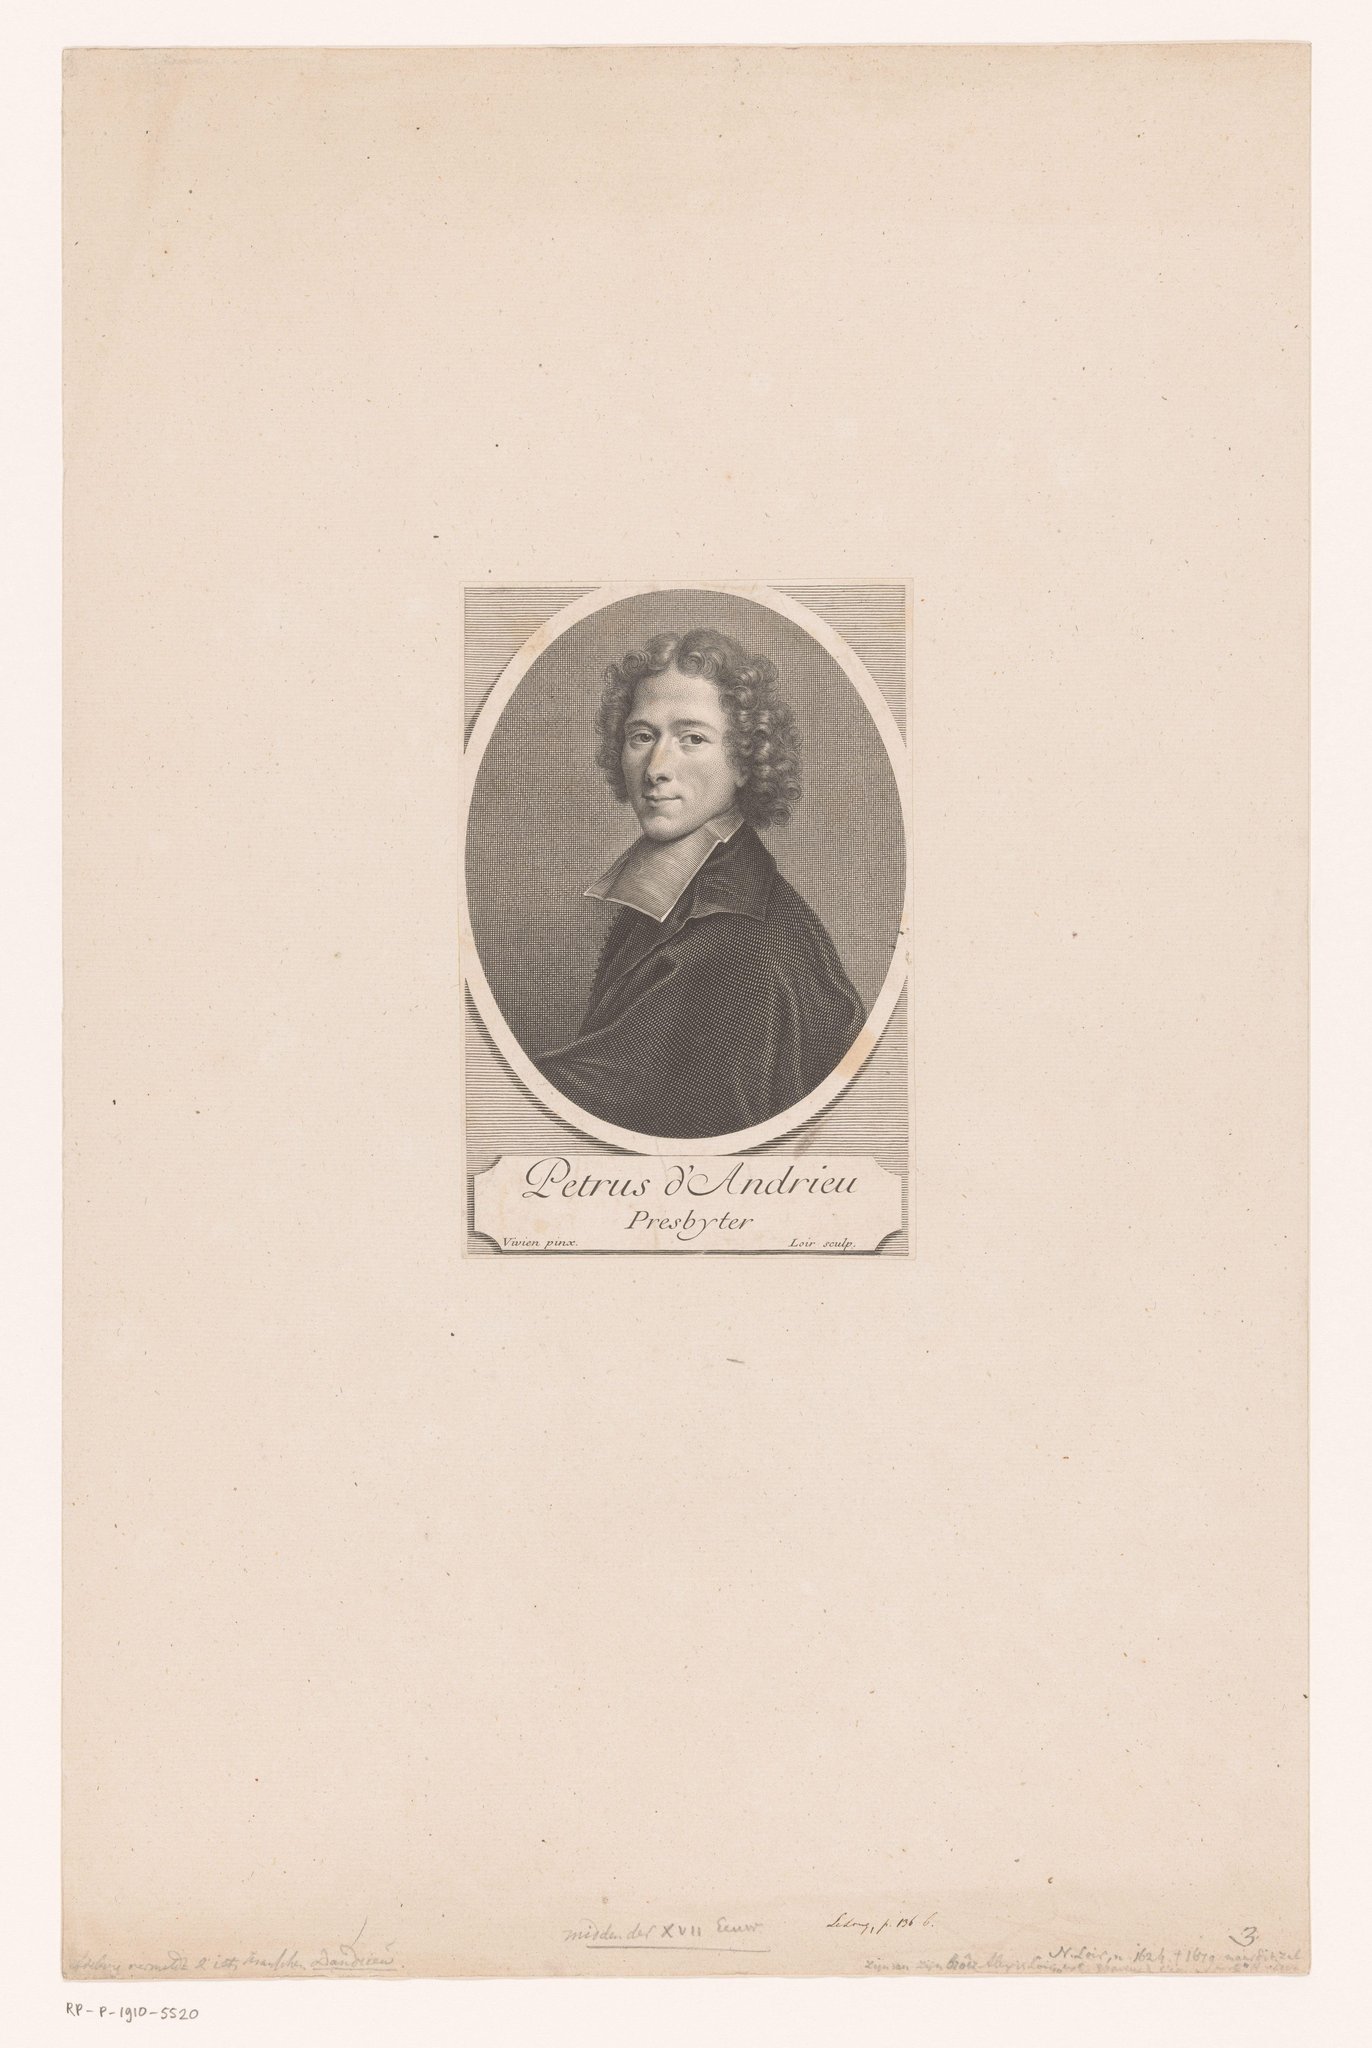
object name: print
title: Portret van Petrus d'Andrieu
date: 1667-1713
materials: paper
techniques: engraving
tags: historical persons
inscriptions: collector's mark: Lugt 2228